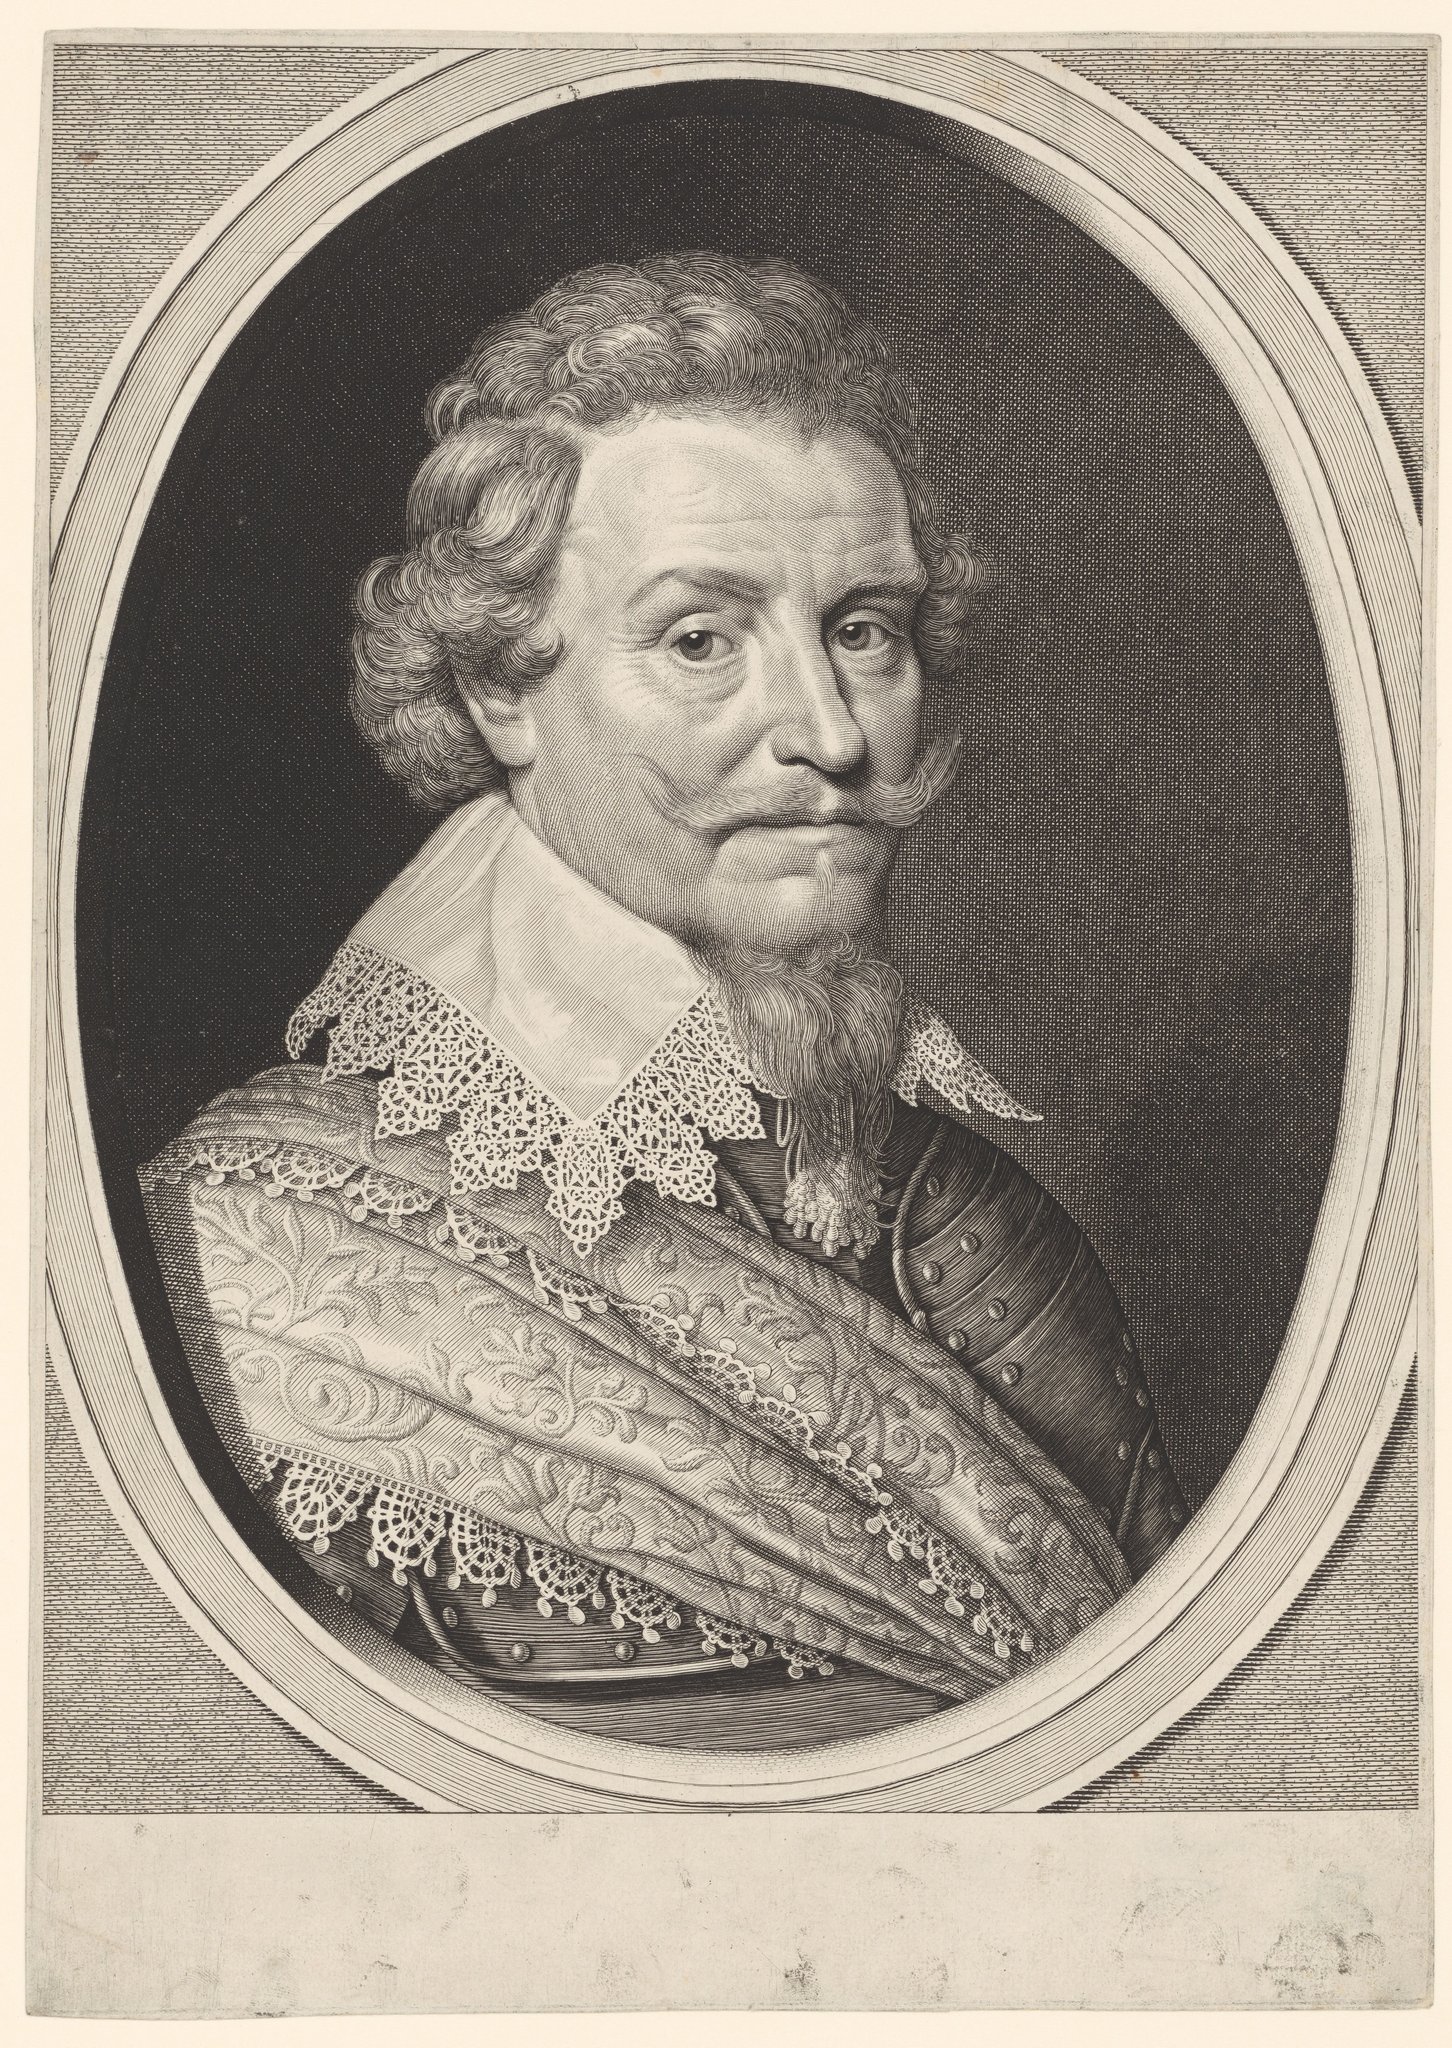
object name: print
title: Portret van Ernst Casimir, graaf van Nassau-Dietz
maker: willem jacobsz delff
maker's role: draughtsman, print maker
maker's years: 1580-1638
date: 1628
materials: paper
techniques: engraving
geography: delft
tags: ernst casimir graaf van nassau-dietz, governor, etc. of province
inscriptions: collector's mark: Lugt 2228, collector's mark: Lugt 963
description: Portret van Ernst Casimir, graaf van Nassau-Dietz, borststuk met kanten kraag en sjerp over harnas in ovale omlijsting zonder opschrift. Met vingerafdrukken van drukker in ondermarge.